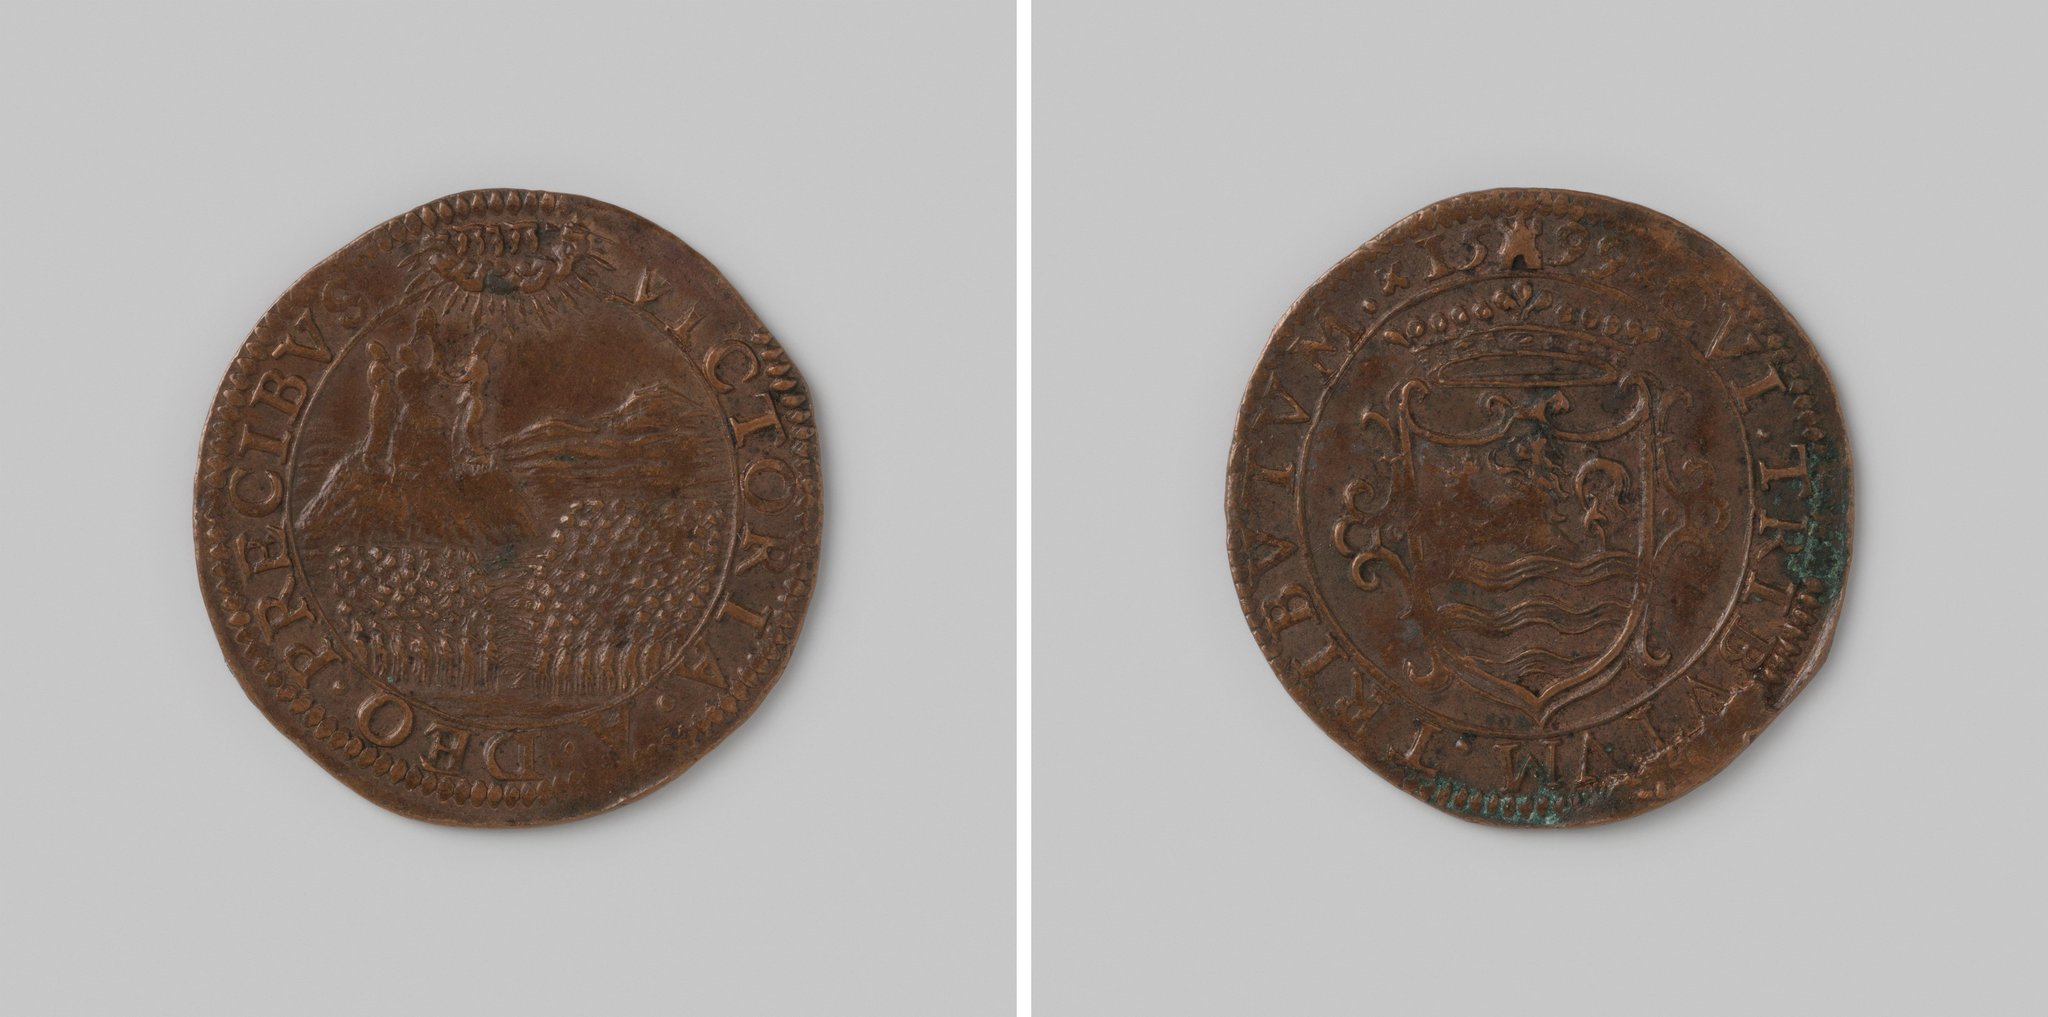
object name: jeton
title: Rekenpenning uit Middelburg op de overwinningen van Prins Maurits 1599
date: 1599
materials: copper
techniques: striking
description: Koperen penning, op de voorzijde een veldslag der Israëlieten met Moses, Aaron en Hur op een berg, op de keerzijde het gekroonde wapenschild van Zeeland, met omschrift.